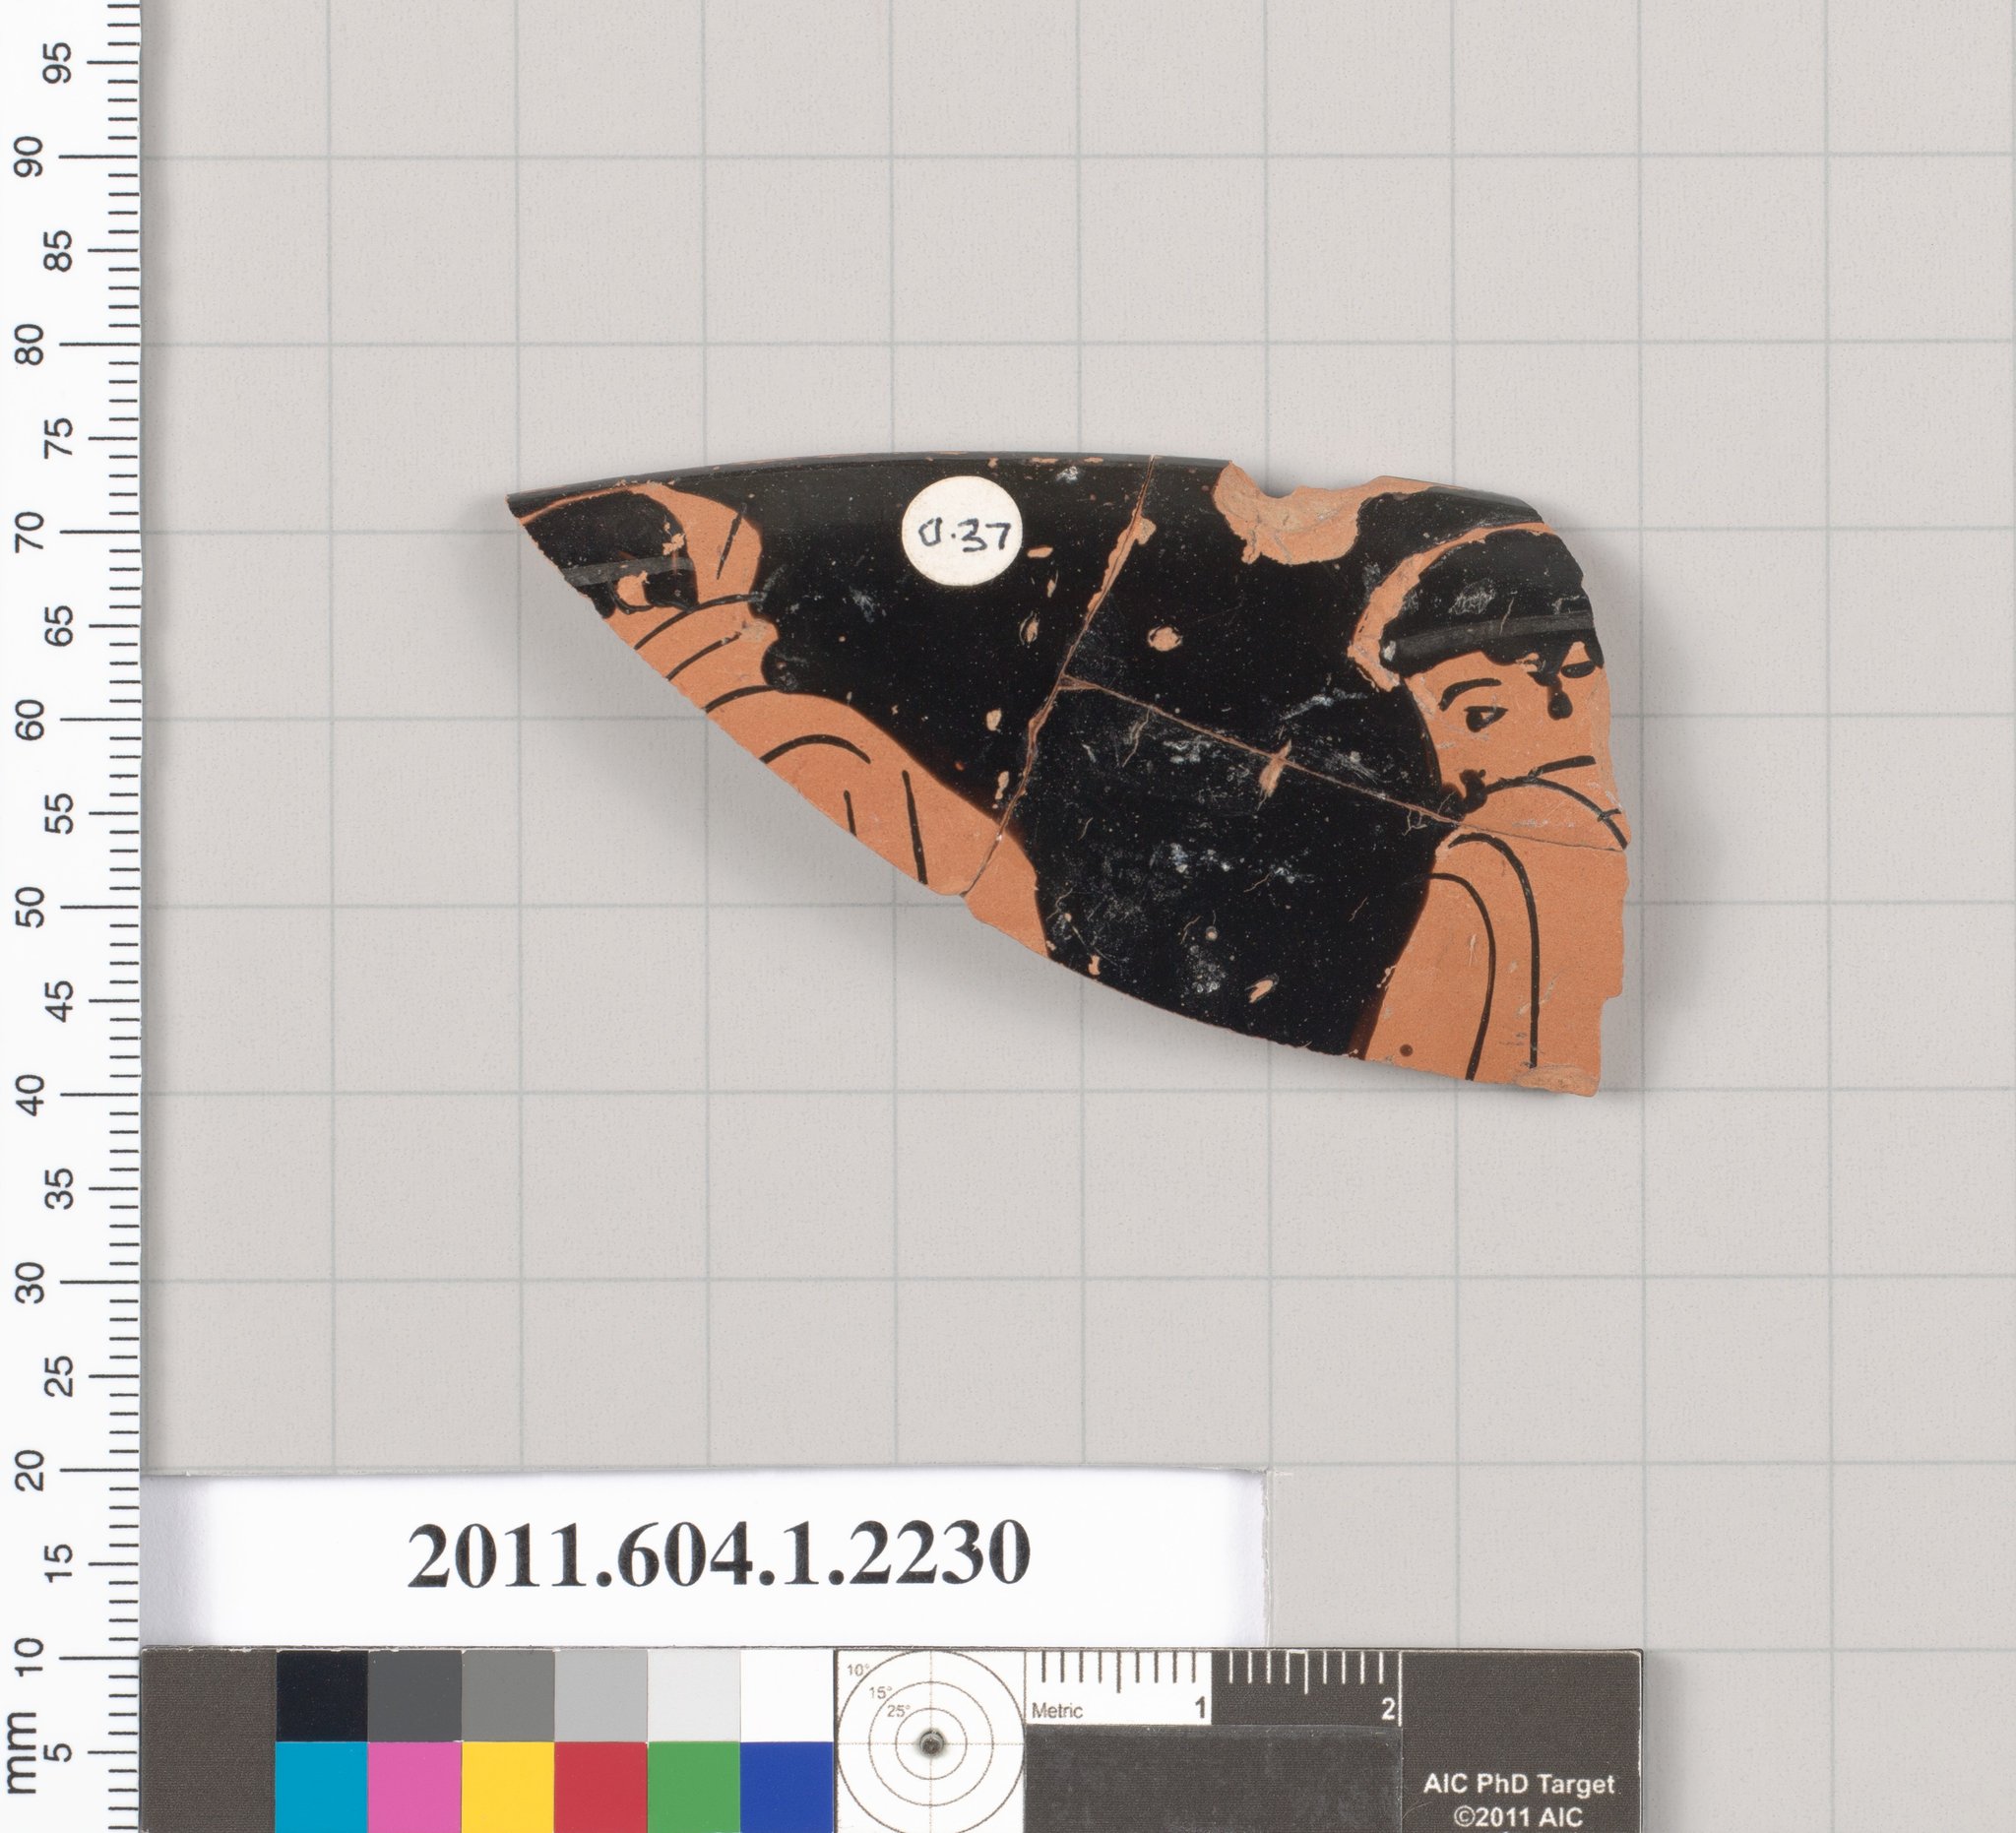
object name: kylix fragment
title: Terracotta rim fragment of a kylix (drinking cup)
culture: greek, attic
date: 475-451 BCE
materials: terracotta